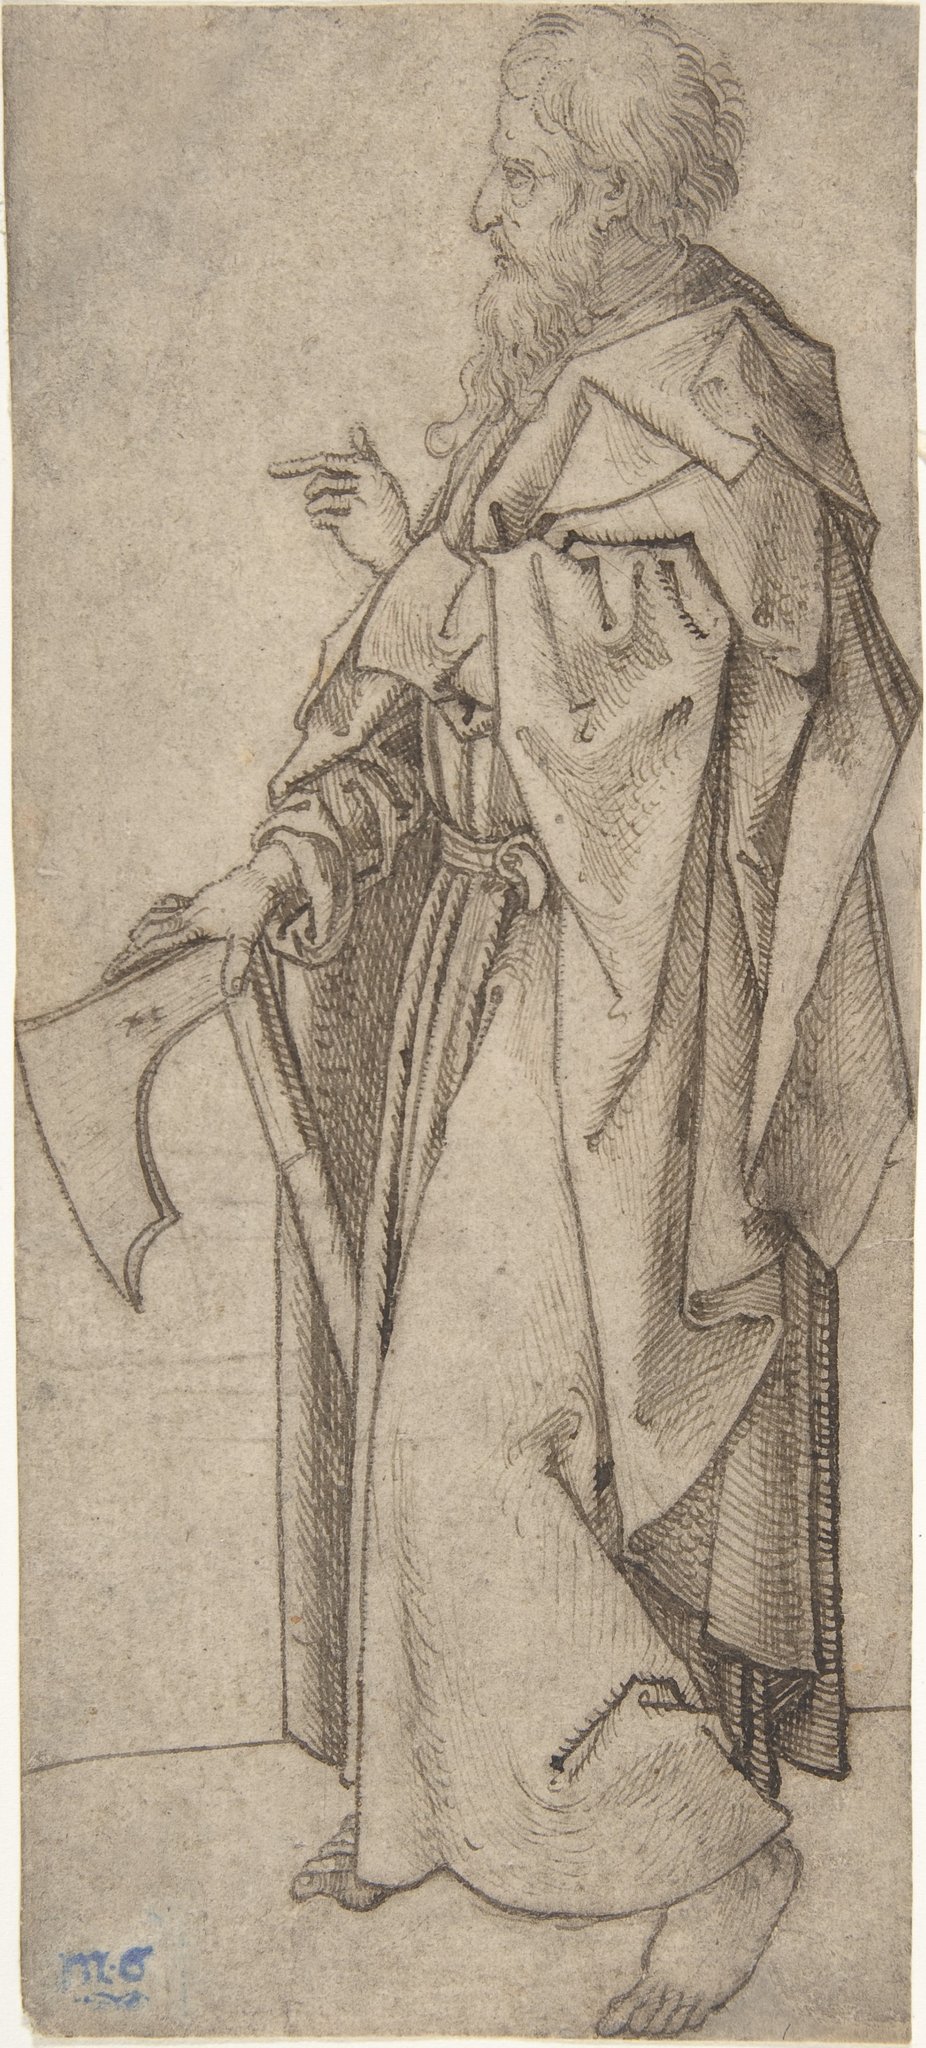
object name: drawing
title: St. Matthew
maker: martin schongauer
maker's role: artist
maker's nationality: german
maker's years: 1430-1491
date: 1451-1500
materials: ink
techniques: pen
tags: saint matthew